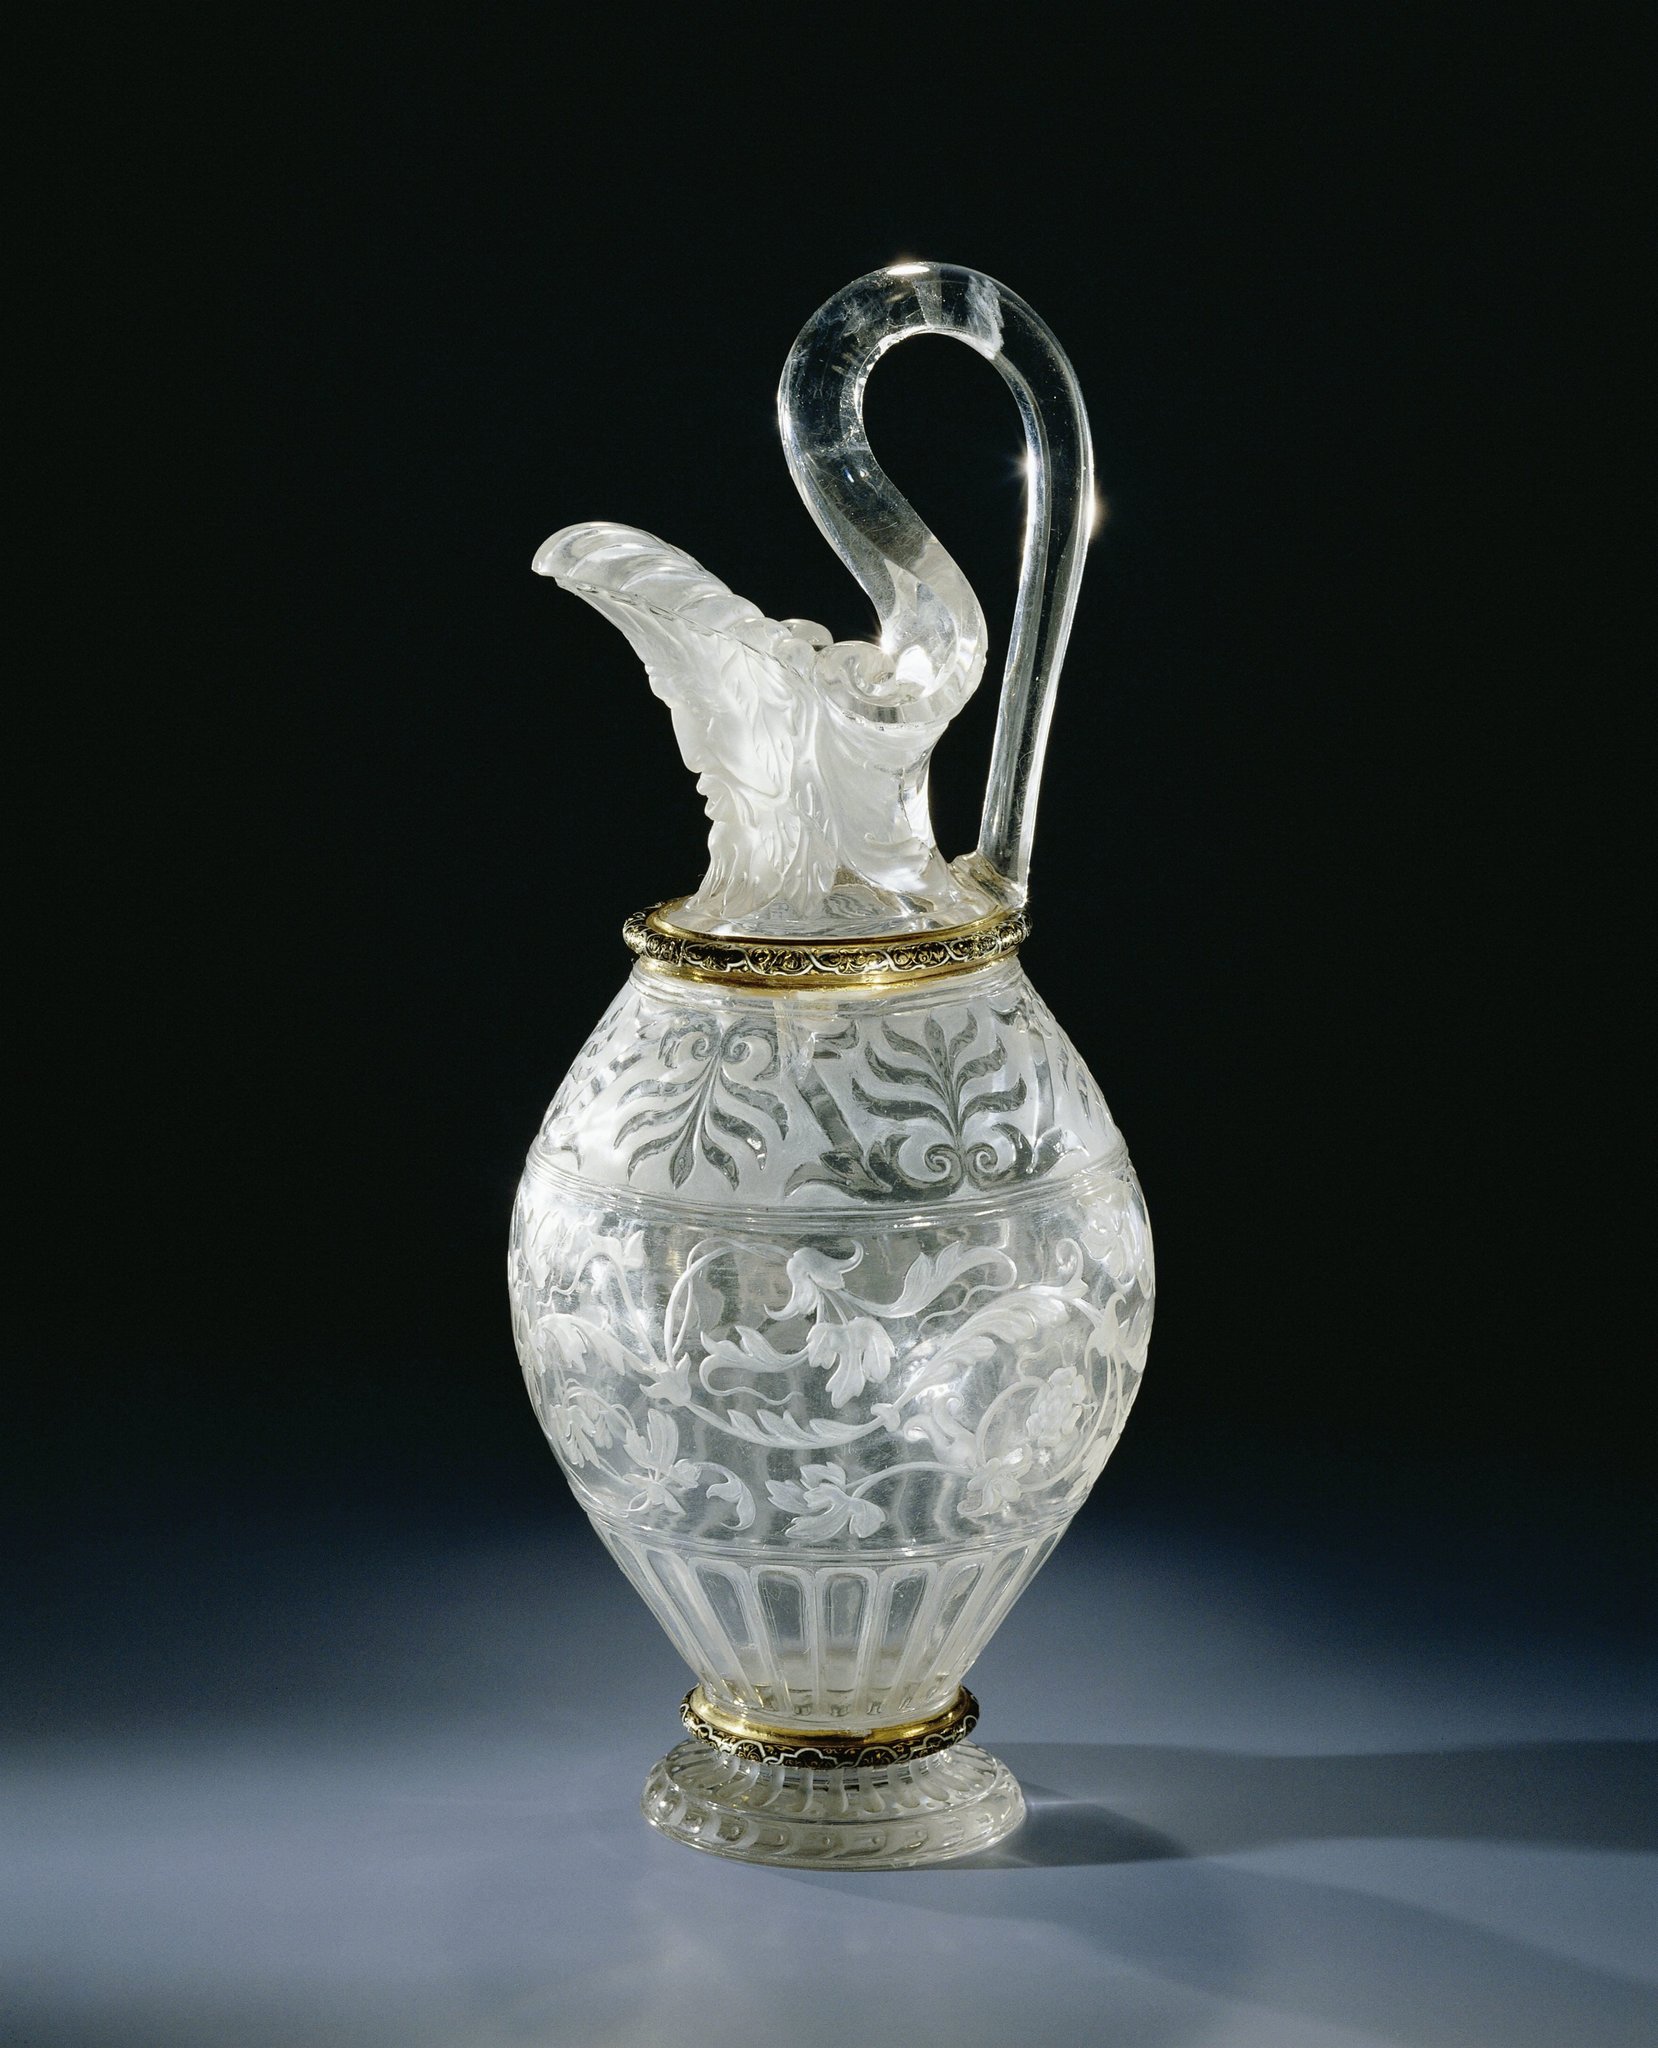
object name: ewer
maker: Anonymous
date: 1550-1570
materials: gold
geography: france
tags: ornament derived from plant forms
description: This ewer is made up of three parts. The foot and the body are turned from large chunks of rock crystal, into which the surface decoration was subsequently carved. A different technique was used for the neck and the handle, which were cut from a third single piece of crystal.